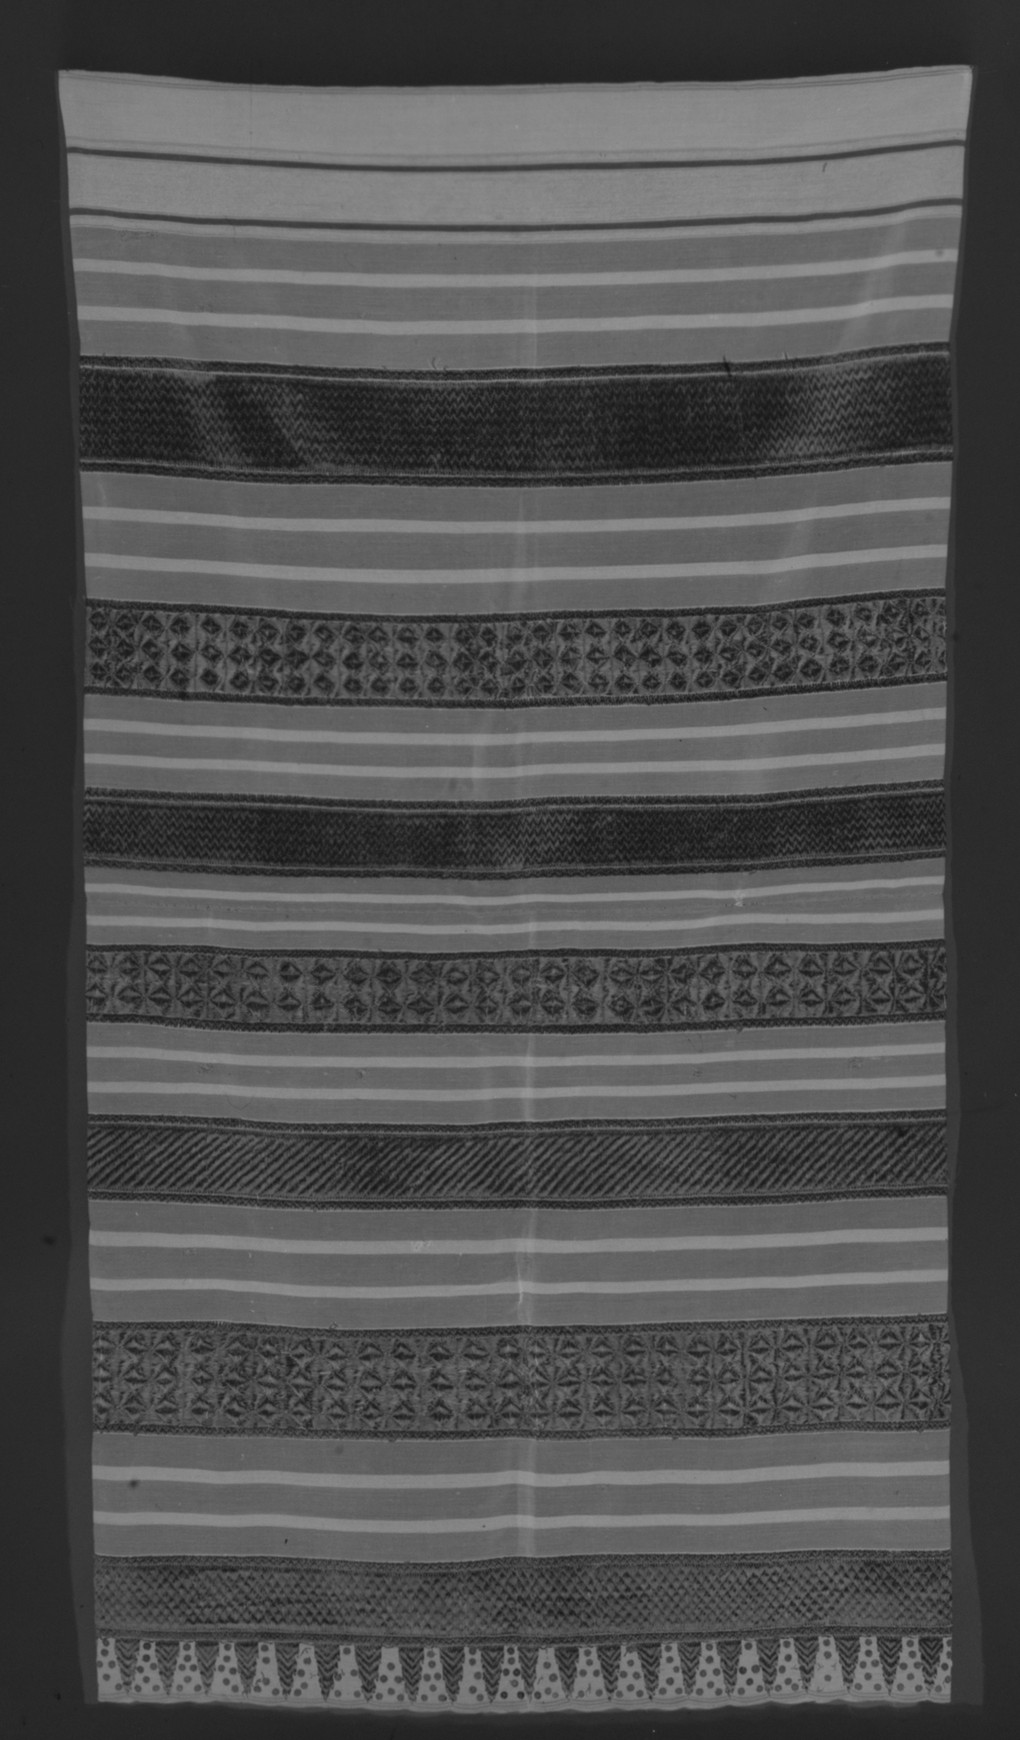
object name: skirt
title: Woman's Ceremonial Skirt (Tapis)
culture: lampung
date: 1801-1900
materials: cotton, gold, silver, thread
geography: indonesia